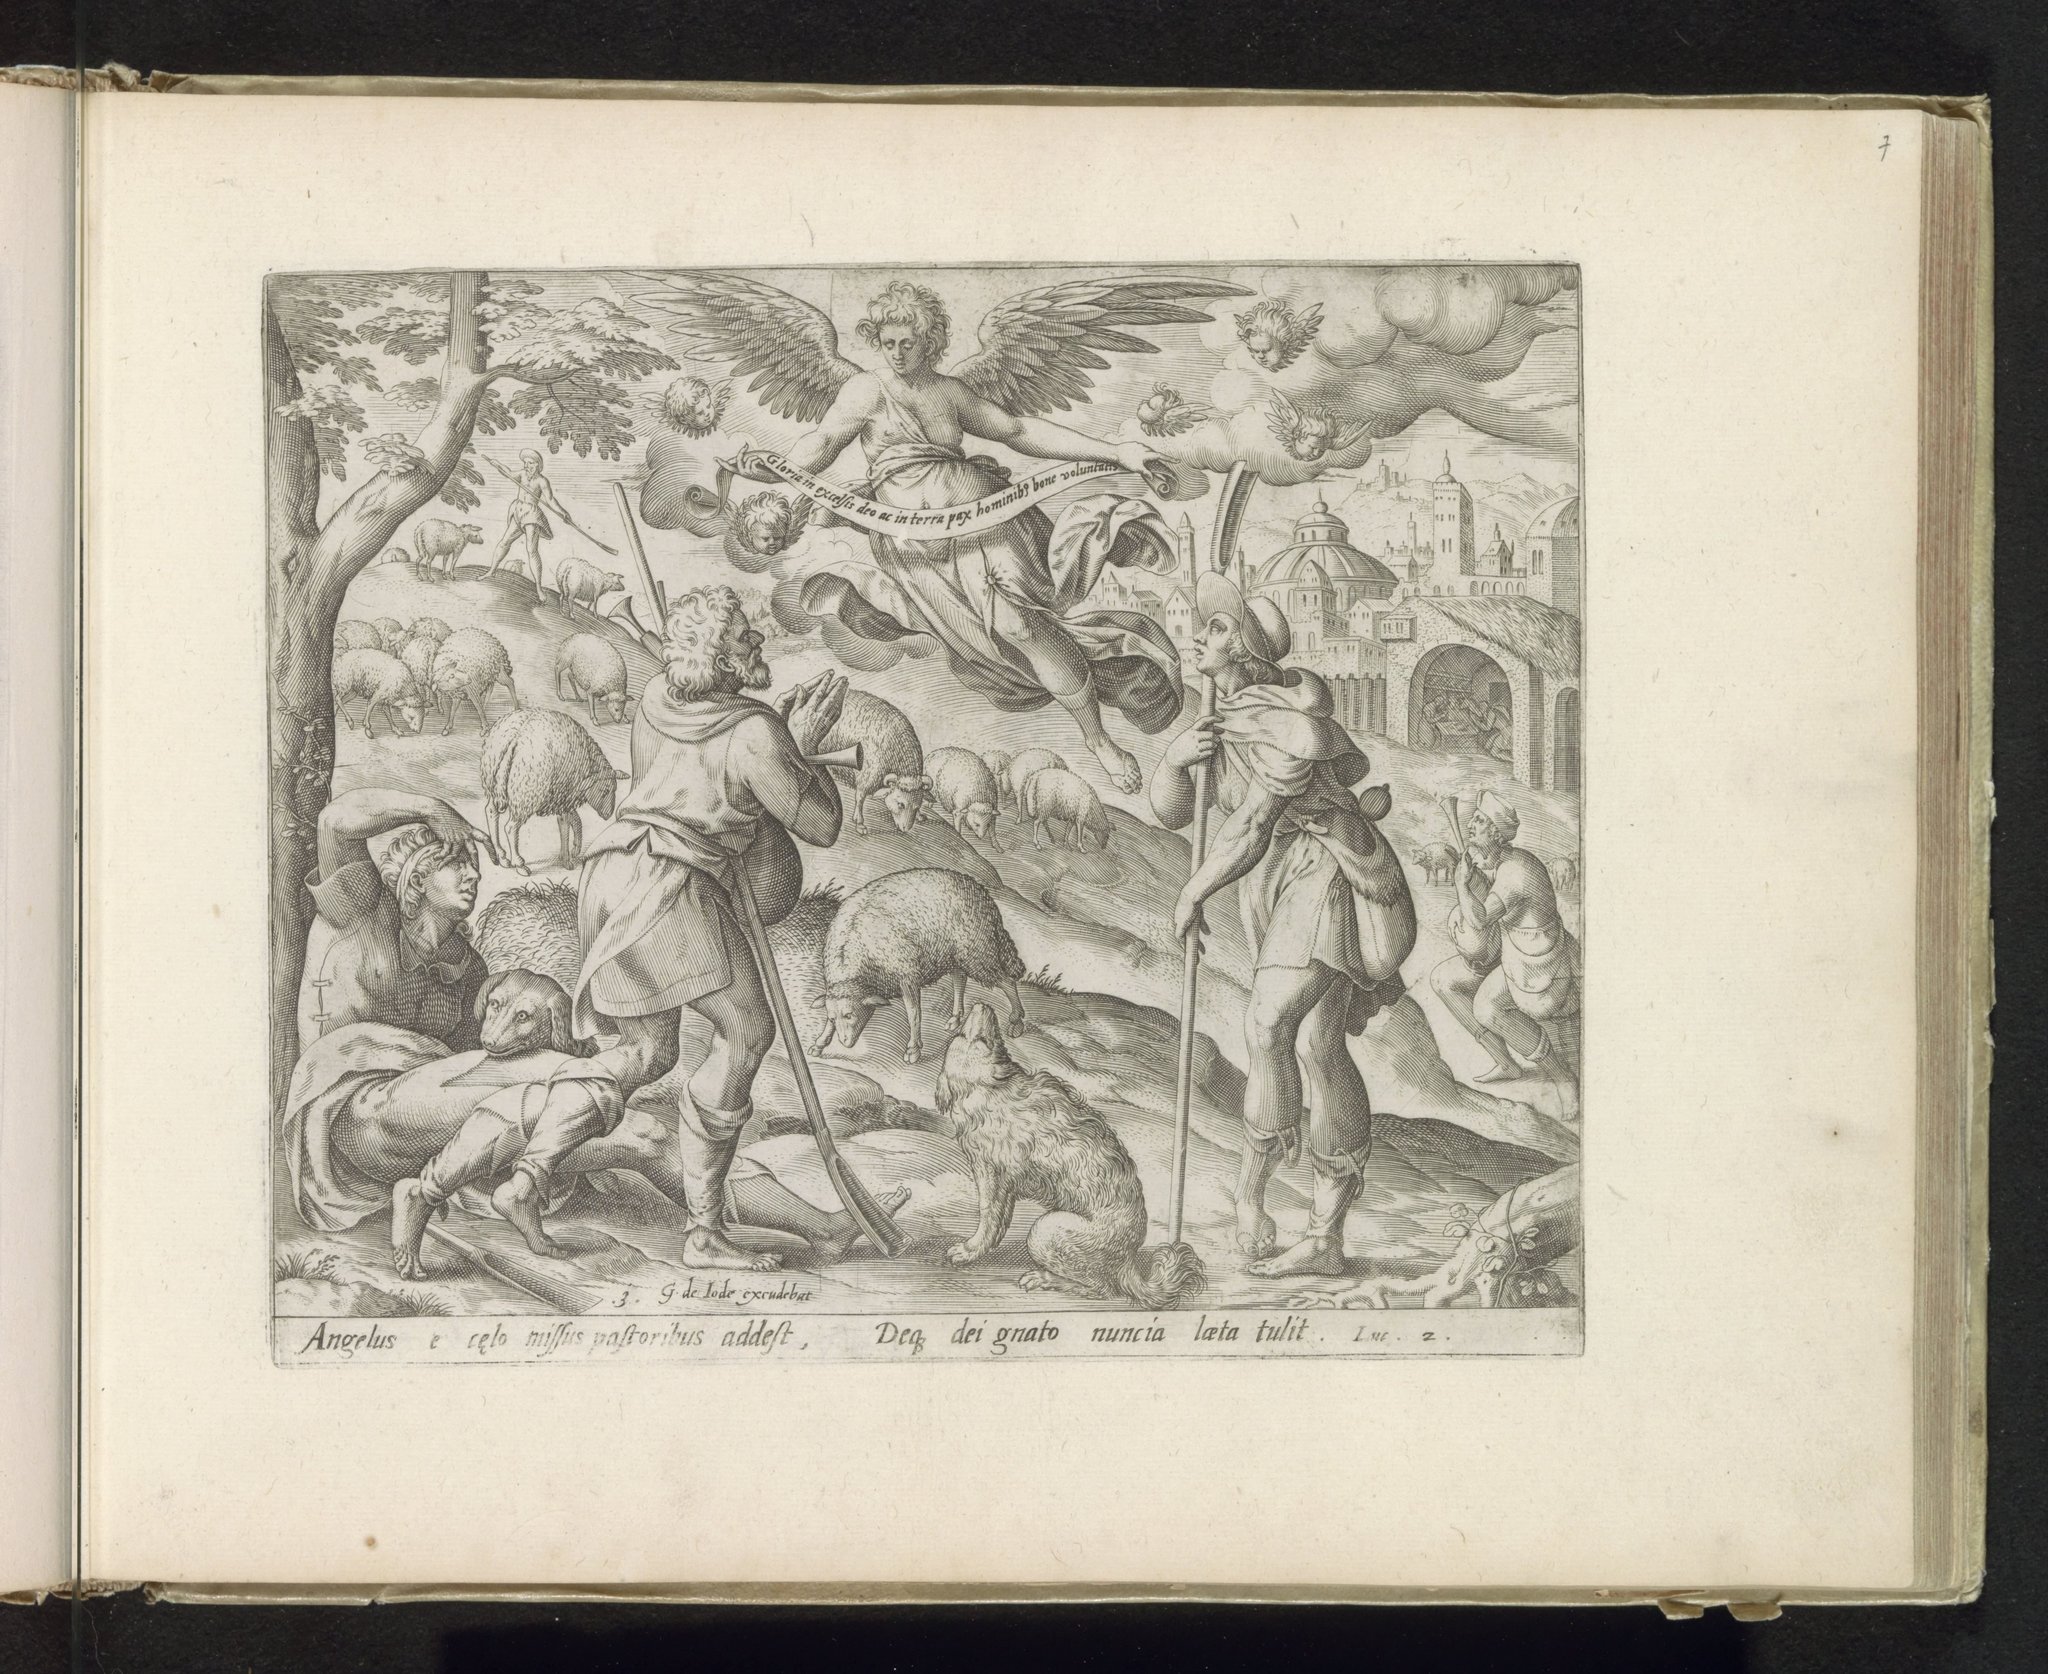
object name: print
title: Jeugd van Christus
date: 1585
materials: paper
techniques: engraving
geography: antwerp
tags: annunciation of christ's birth to the shepherds (and/or shepherdesses) at night; a host of singing angels in the air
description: Een engel verkondigt de geboorte van Christus aan de herders, die met hun schapen op het veld zijn. Rechts op de achtergrond de stal met Maria en Jozef bij de kribbe. Onder de voorstelling een verwijzing in het Latijn naar de Bijbeltekst in Luc. 2. Deze prent maakt deel uit van een album.